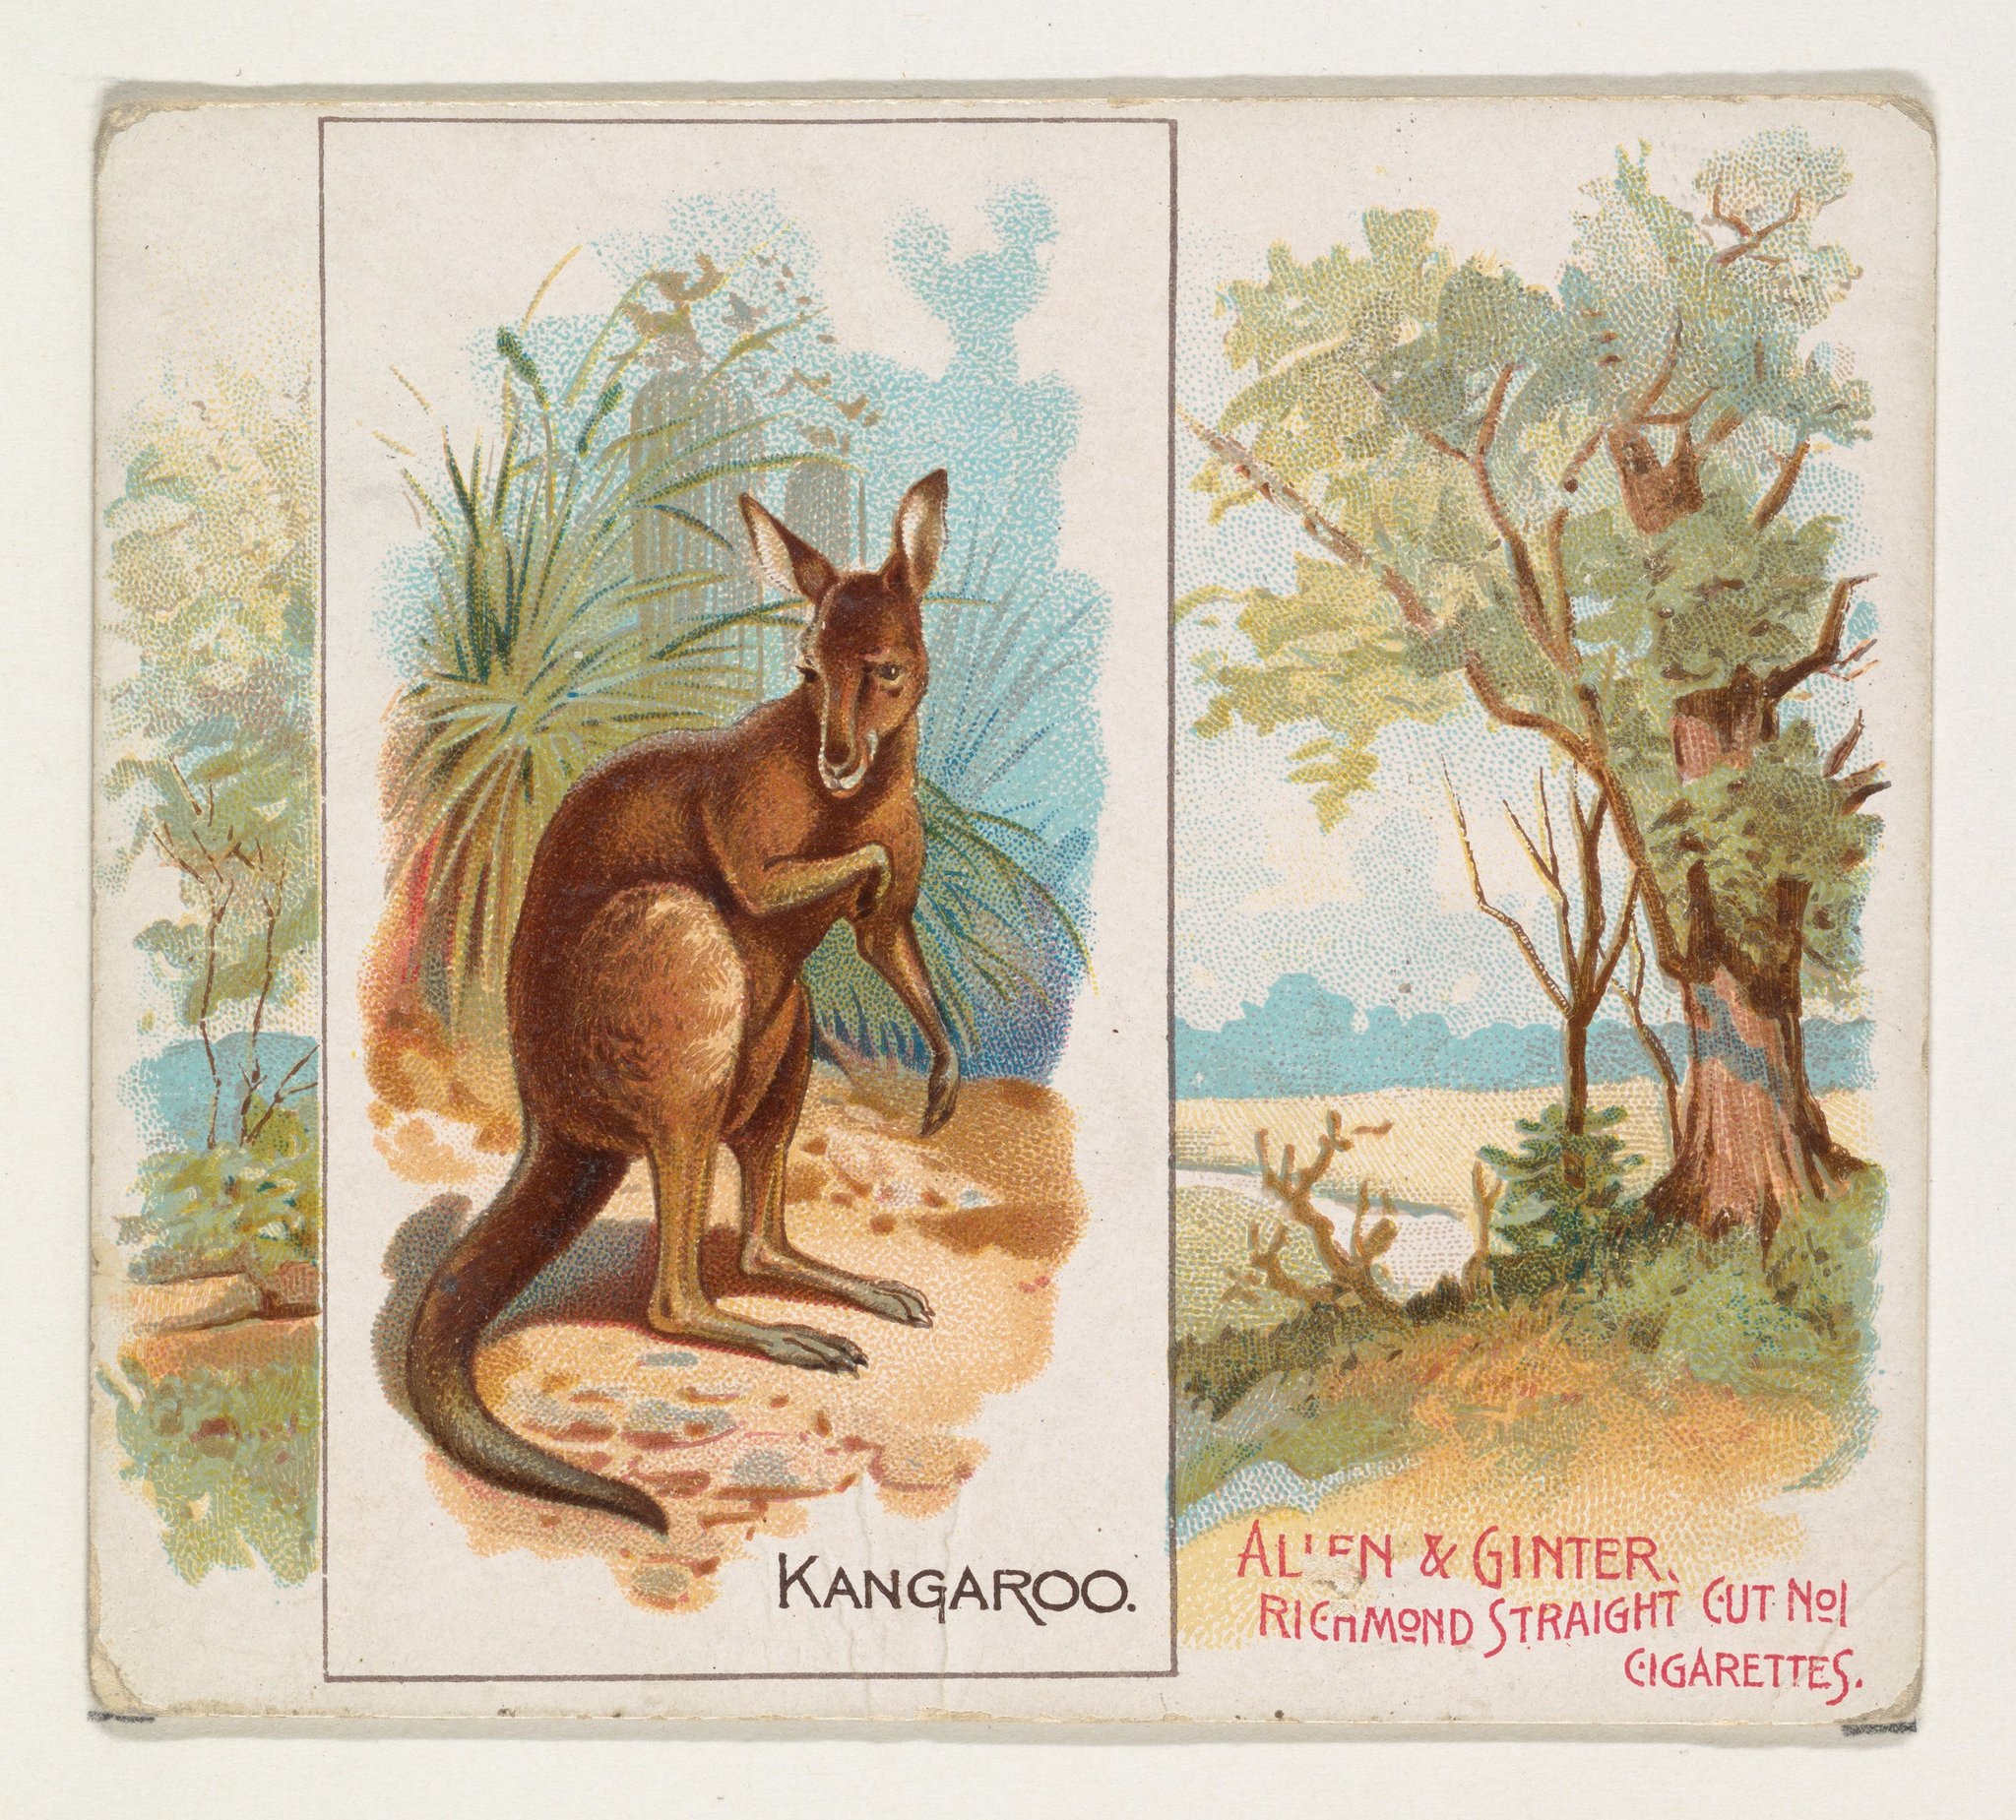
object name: print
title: Kangaroo, from Quadrupeds series (N41) for Allen & Ginter Cigarettes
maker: allen & ginter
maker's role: publisher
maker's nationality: american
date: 1890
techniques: color lithograph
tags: animals